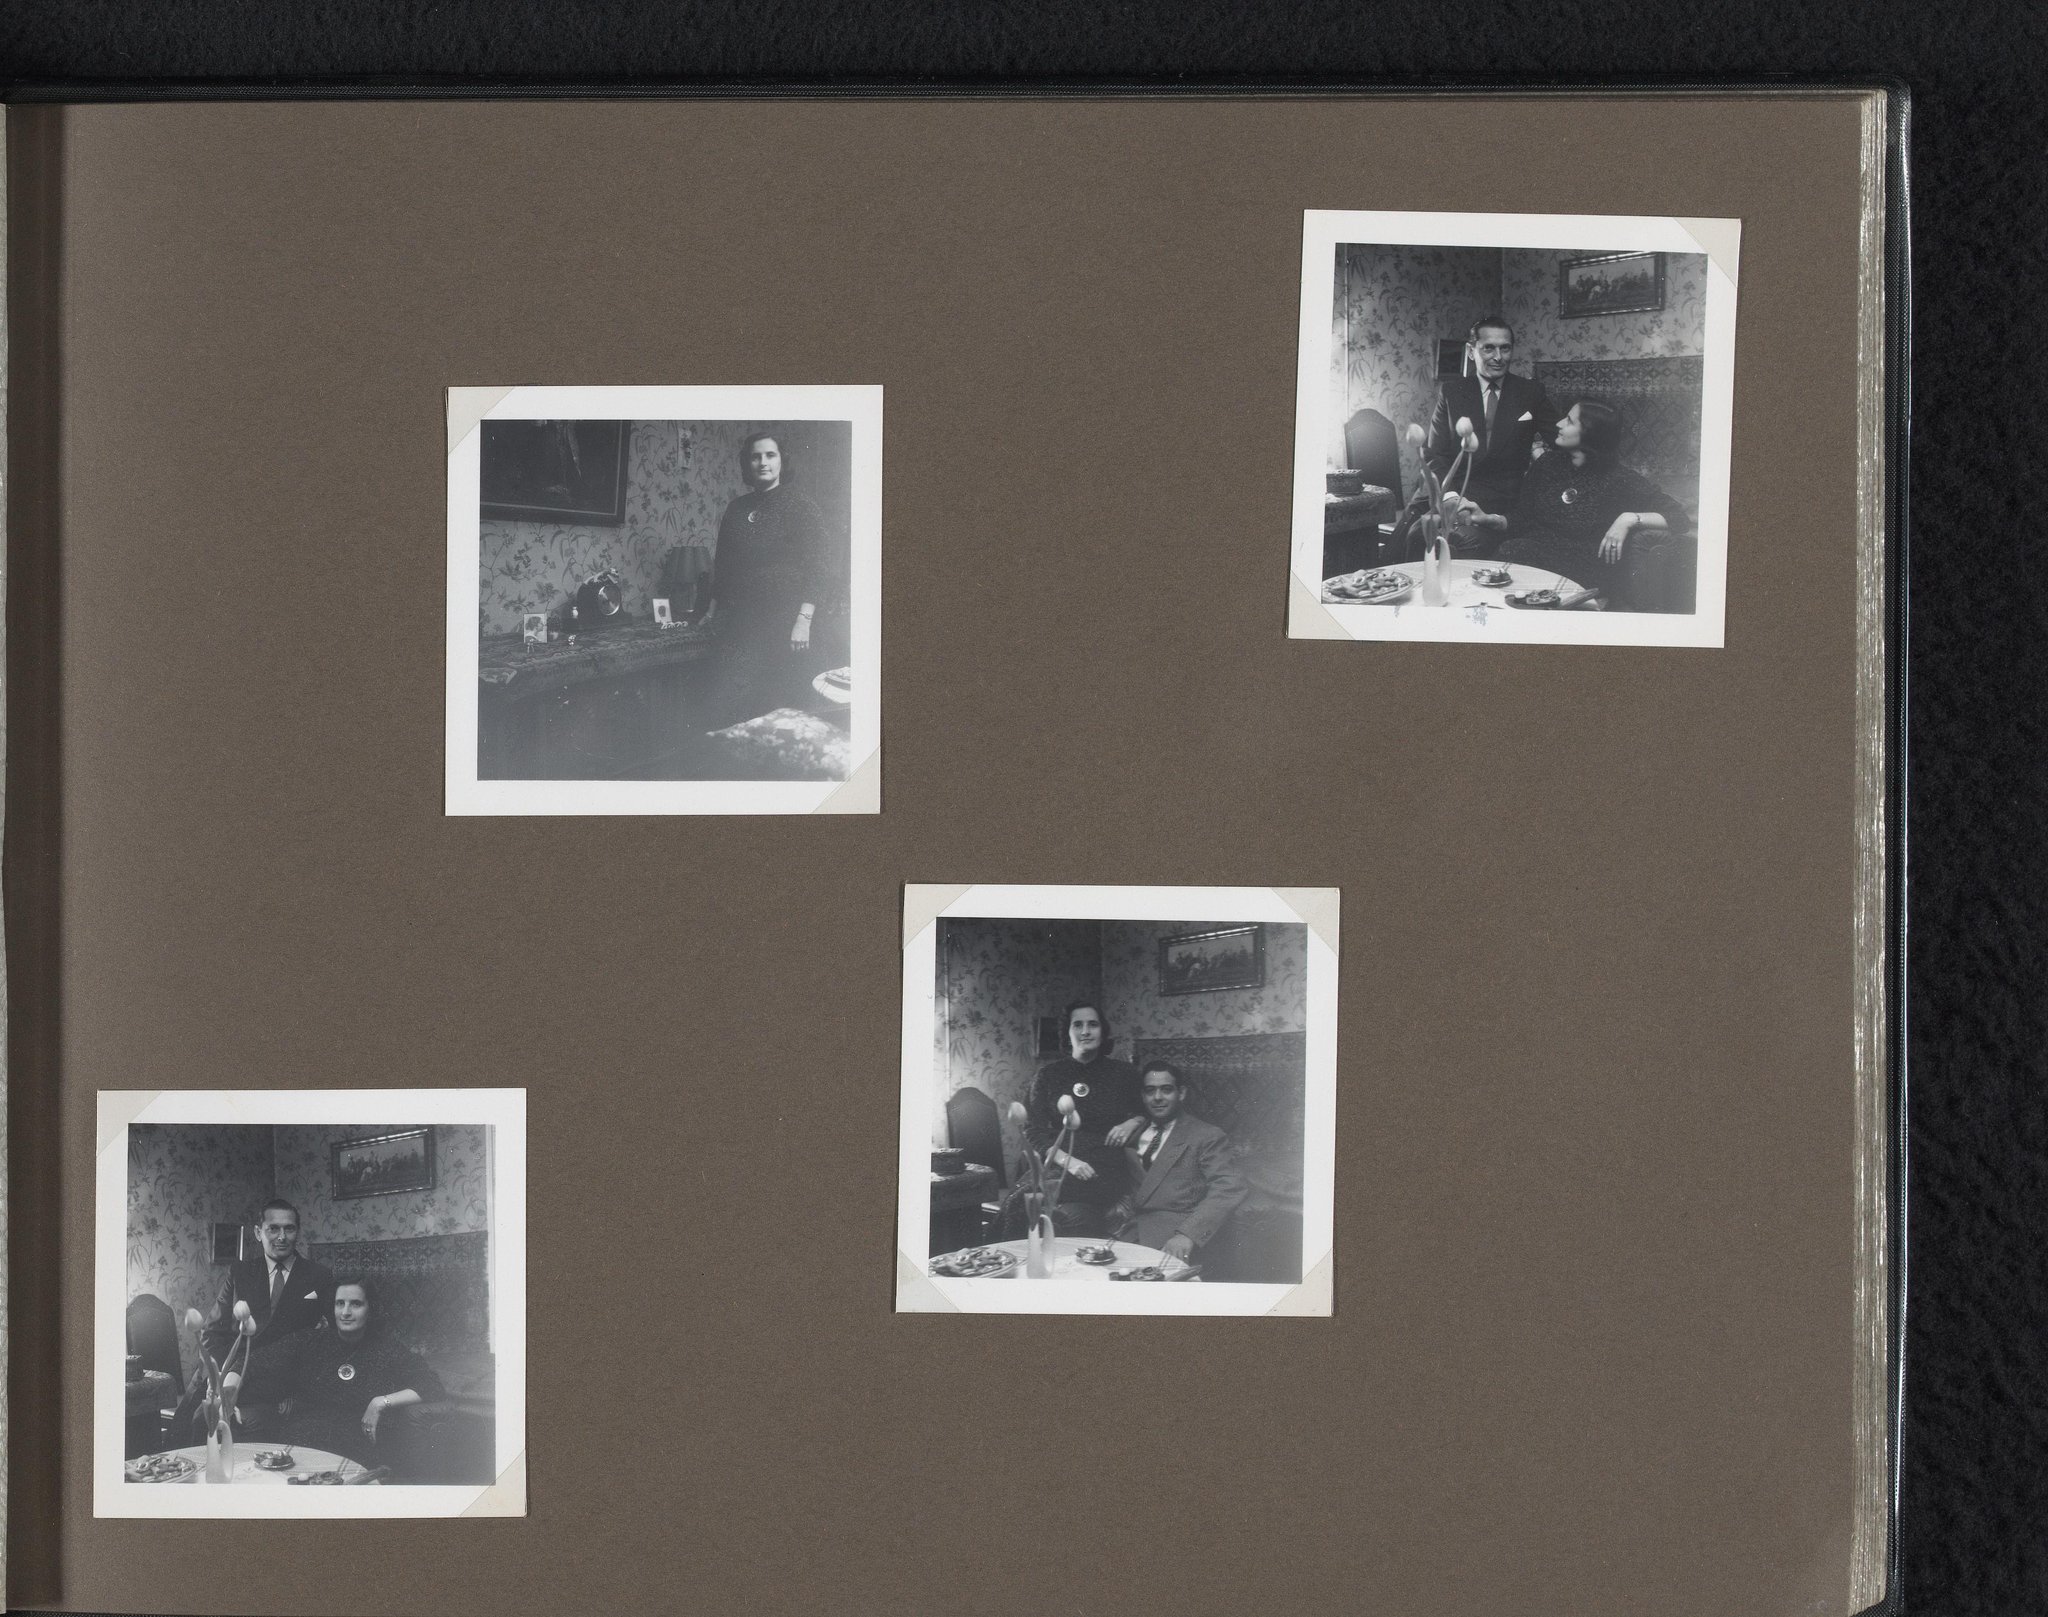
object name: photograph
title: Portretten van Isabel Wachenheimer, haar derde echtgenoot Gideon Elon en een man in een huiskamer, mogelijk in Duitsland of Nederland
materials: paper, cardboard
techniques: gelatin silver print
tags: isabel wachenheimer-elon, gideon elon, historical persons, interior of the house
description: Blad bevat vier foto's van Isabel Wachenheimer, Gideon Elon (met pochet) en een man (zonder pochet). Deze foto's maken deel uit van een album.